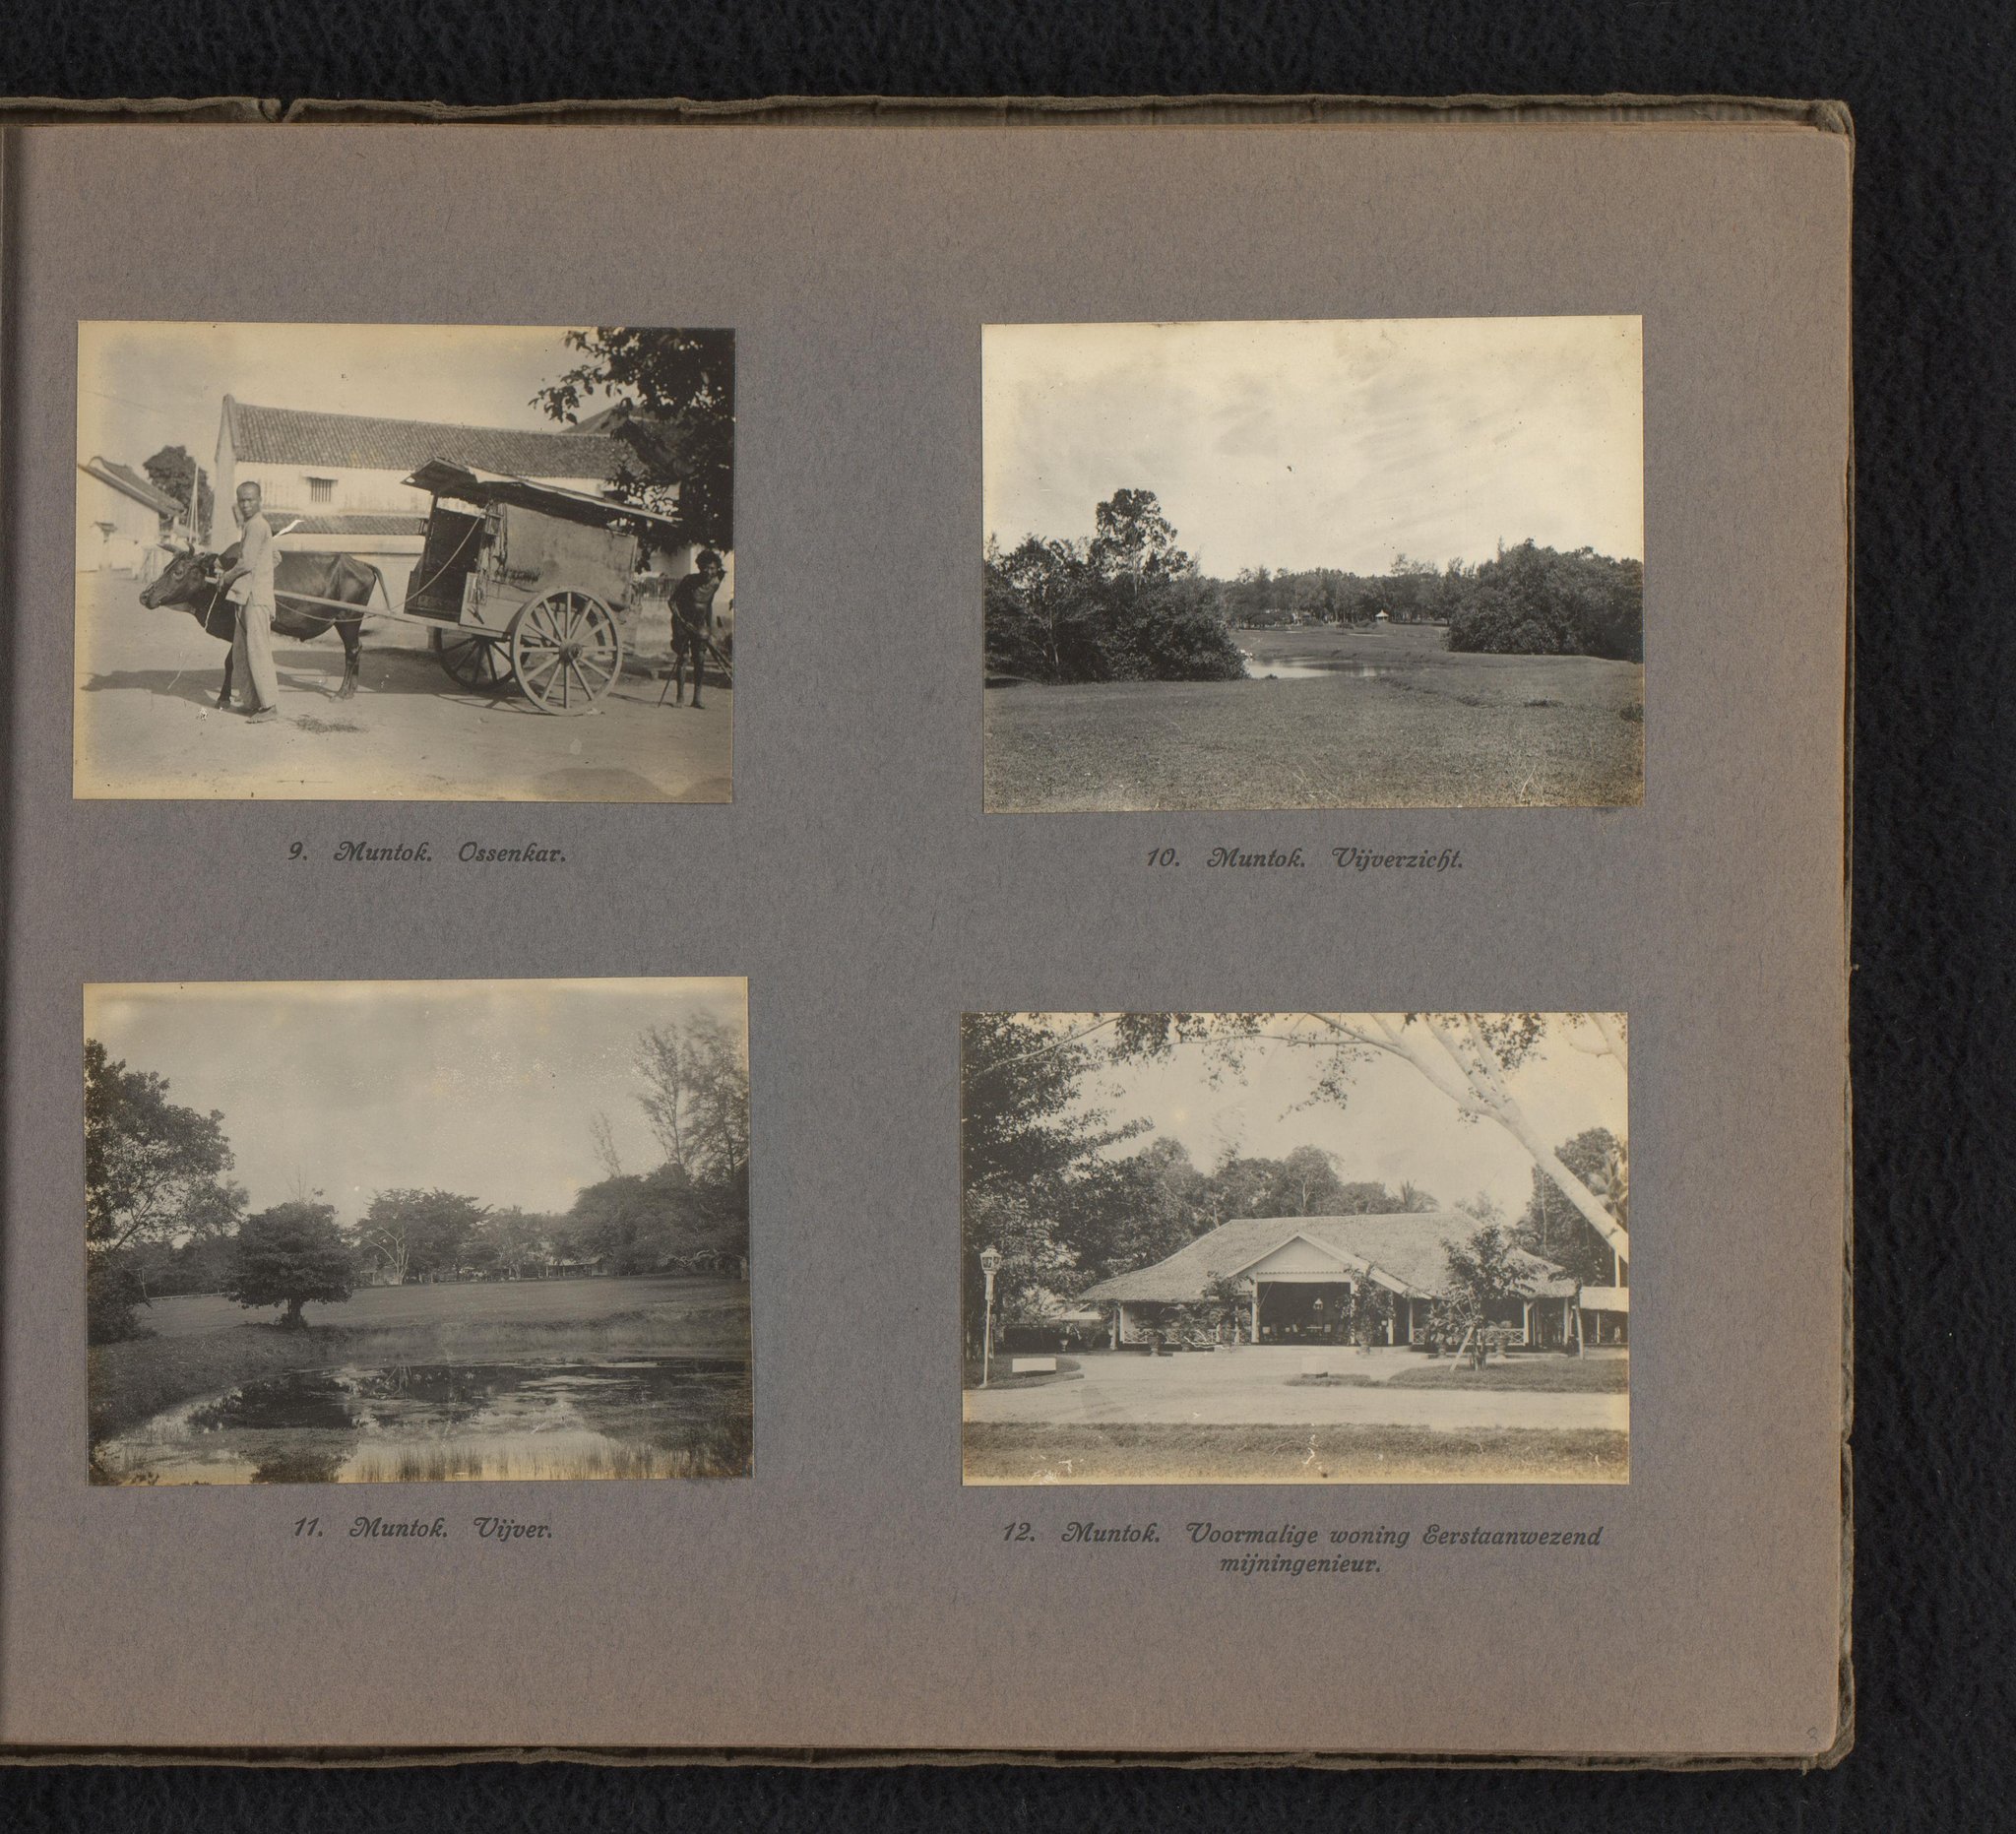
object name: album leaf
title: Gezichten te Muntok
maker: Anonymous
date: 1907-1919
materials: cardboard, photographic support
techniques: gelatin silver print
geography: bangka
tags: robert julius boers, colonial system, landscapes in tropical and sub-tropical regions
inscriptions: inscription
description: Albumblad met vier foto's genummerd 9-12 met diverse gezichten te Muntok op Banka. Onderdeel van het Banka-Album met foto's over het eiland Banka en de tinwinning door het staatsbedrijf de Banka-tinwinning in de periode ca. 1907-1919.